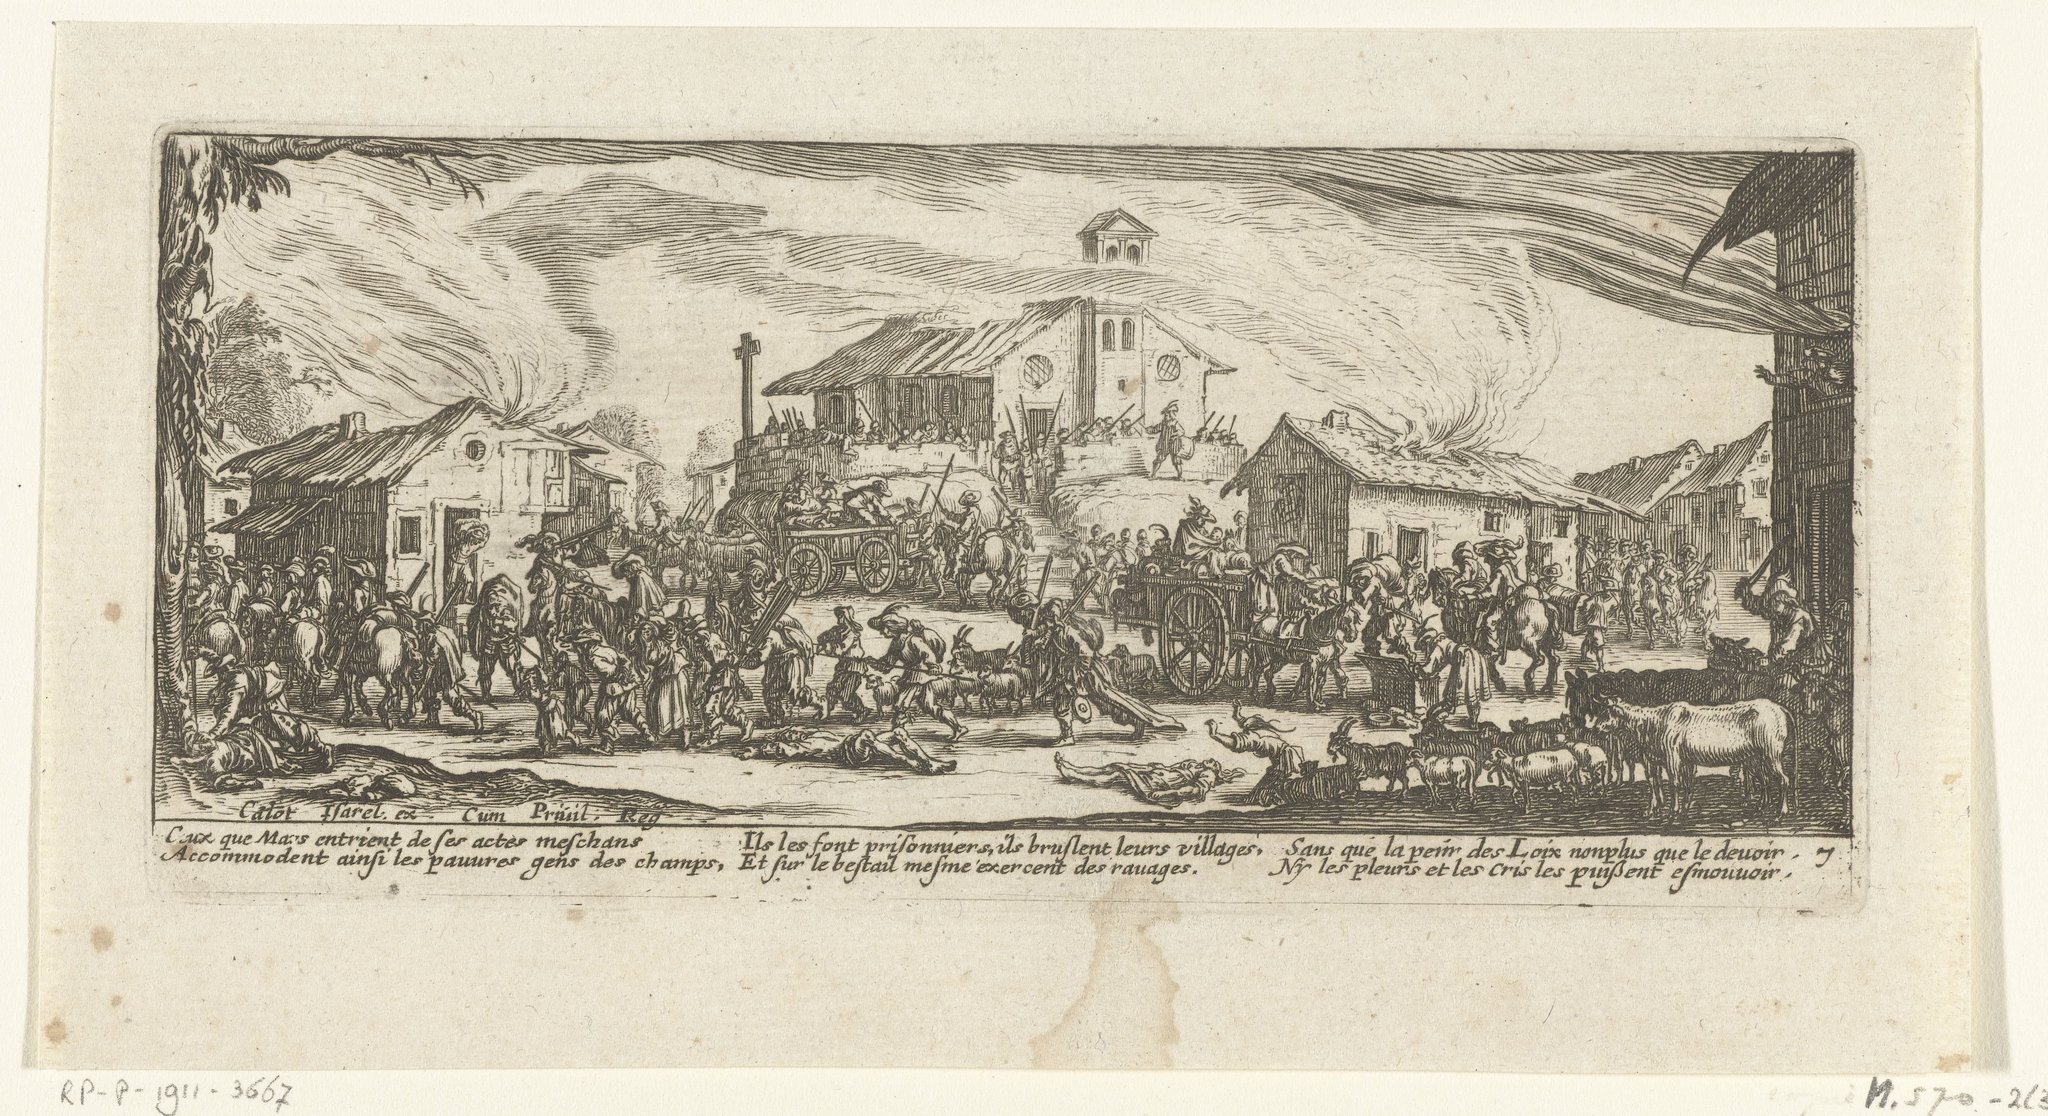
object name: print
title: De droeve ellendigheden van de Oorloogh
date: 1677-1690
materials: paper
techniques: etching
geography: paris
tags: village, plundering ~ soldiers, soldiers and civilians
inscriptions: collector's mark: Lugt 2228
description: In een dorp roven soldaten spullen uit huizen en laden ze op karren. Dorpelingen worden gebonden meegevoerd. De dorpskerk en enkele huizen staan in brand. Onder de voorstelling een zesregelig Frans vers. Deze prent is onderdeel van een serie van 17 (18 incl. titelprent) prenten met voorstellingen van diverse soorten ellende die oorlogvoering met zich meebrengt.